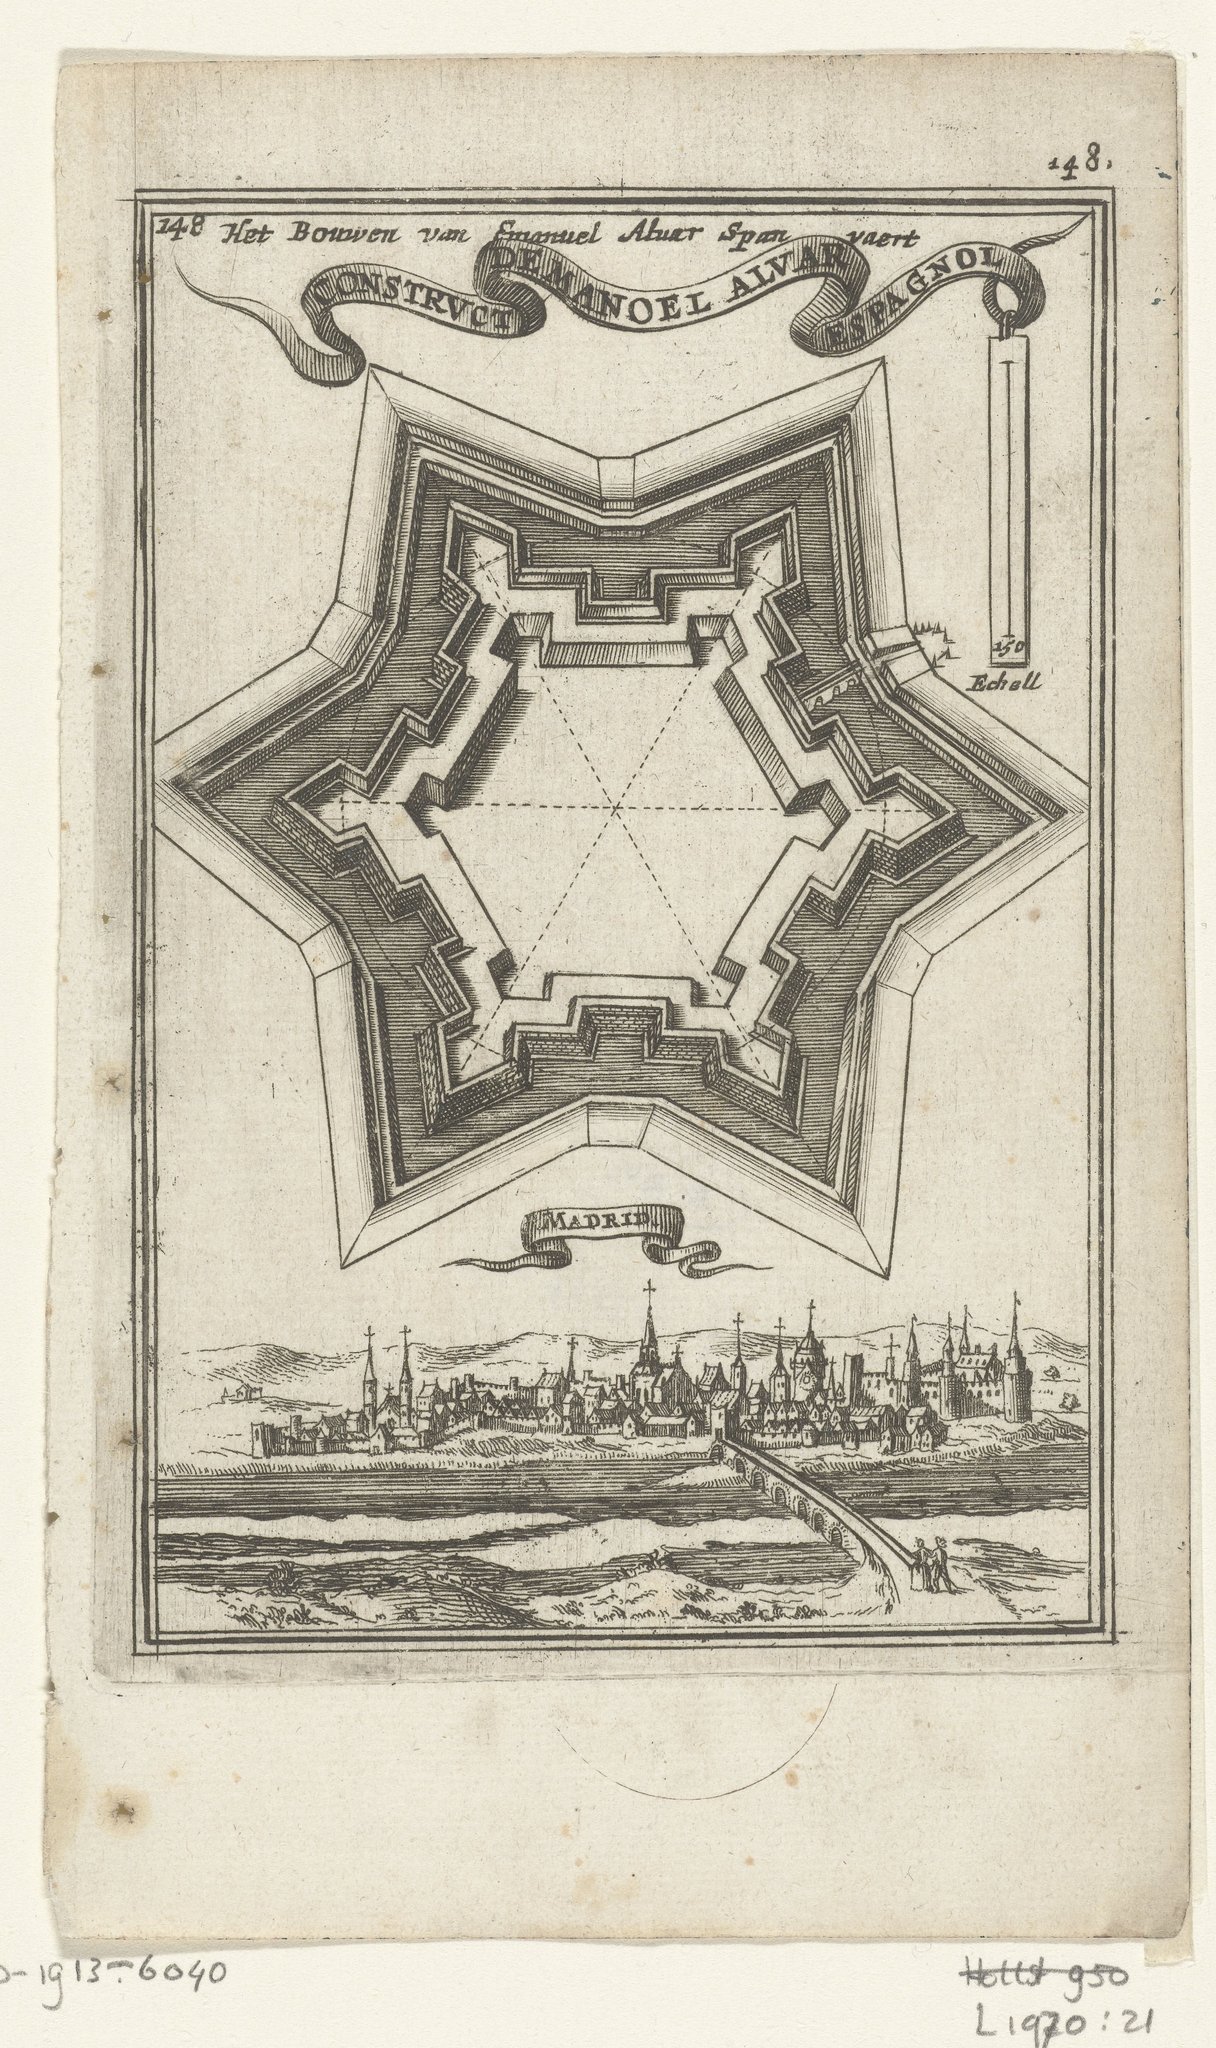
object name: book illustration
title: Illustratie voor 'Den Arbeid van Mars' van Allain Manesson Mallet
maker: romeyn de hooghe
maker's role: draughtsman, goldsmith, painter, print maker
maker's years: 1645-1708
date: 1672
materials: paper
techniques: etching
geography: amsterdam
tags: river, landscape with bridge, viaduct or aqueduct, fortifications, military engineering, prospect of city, town panorama, silhouette of city, mathematics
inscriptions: collector's mark: Lugt 2228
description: Grondplan voor een vesting, fort of versterking (zeshoek). Daaronder een gezicht op een stad aan een rivier (Madrid). In de hoek rechtsboven het cijfer 148 (= het nummer van de pagina in het boek waartegenover de illustratie geplaatst is).